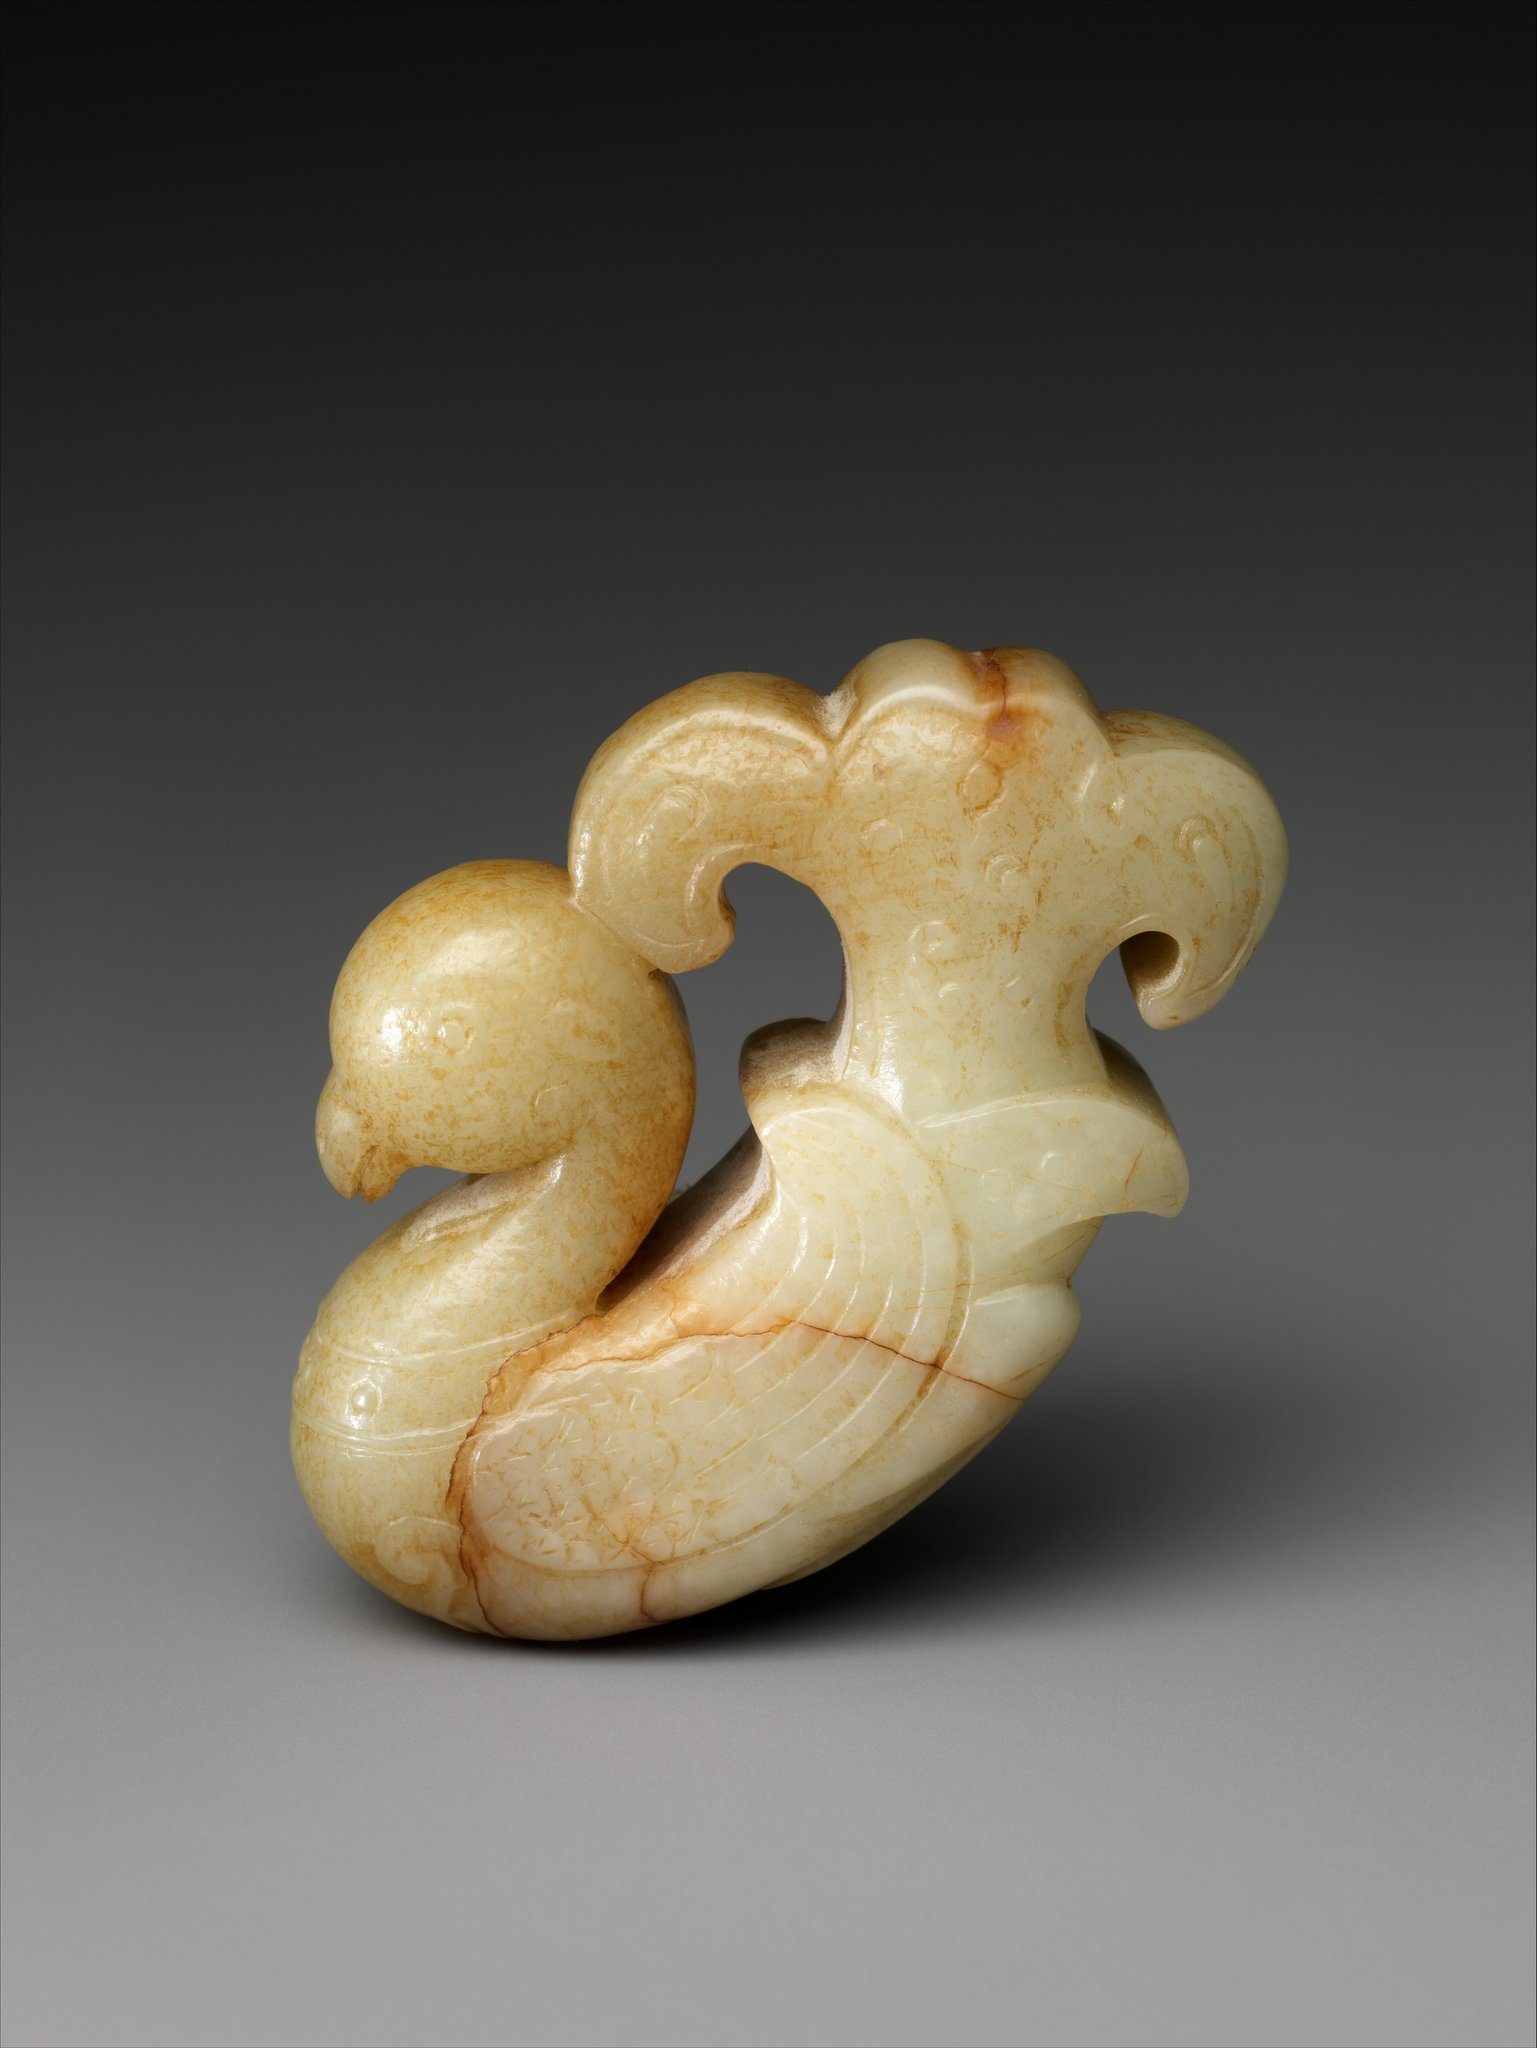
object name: fitting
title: Fitting in the shape of a mythical bird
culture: chinese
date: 701-800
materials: jade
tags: mythical creatures